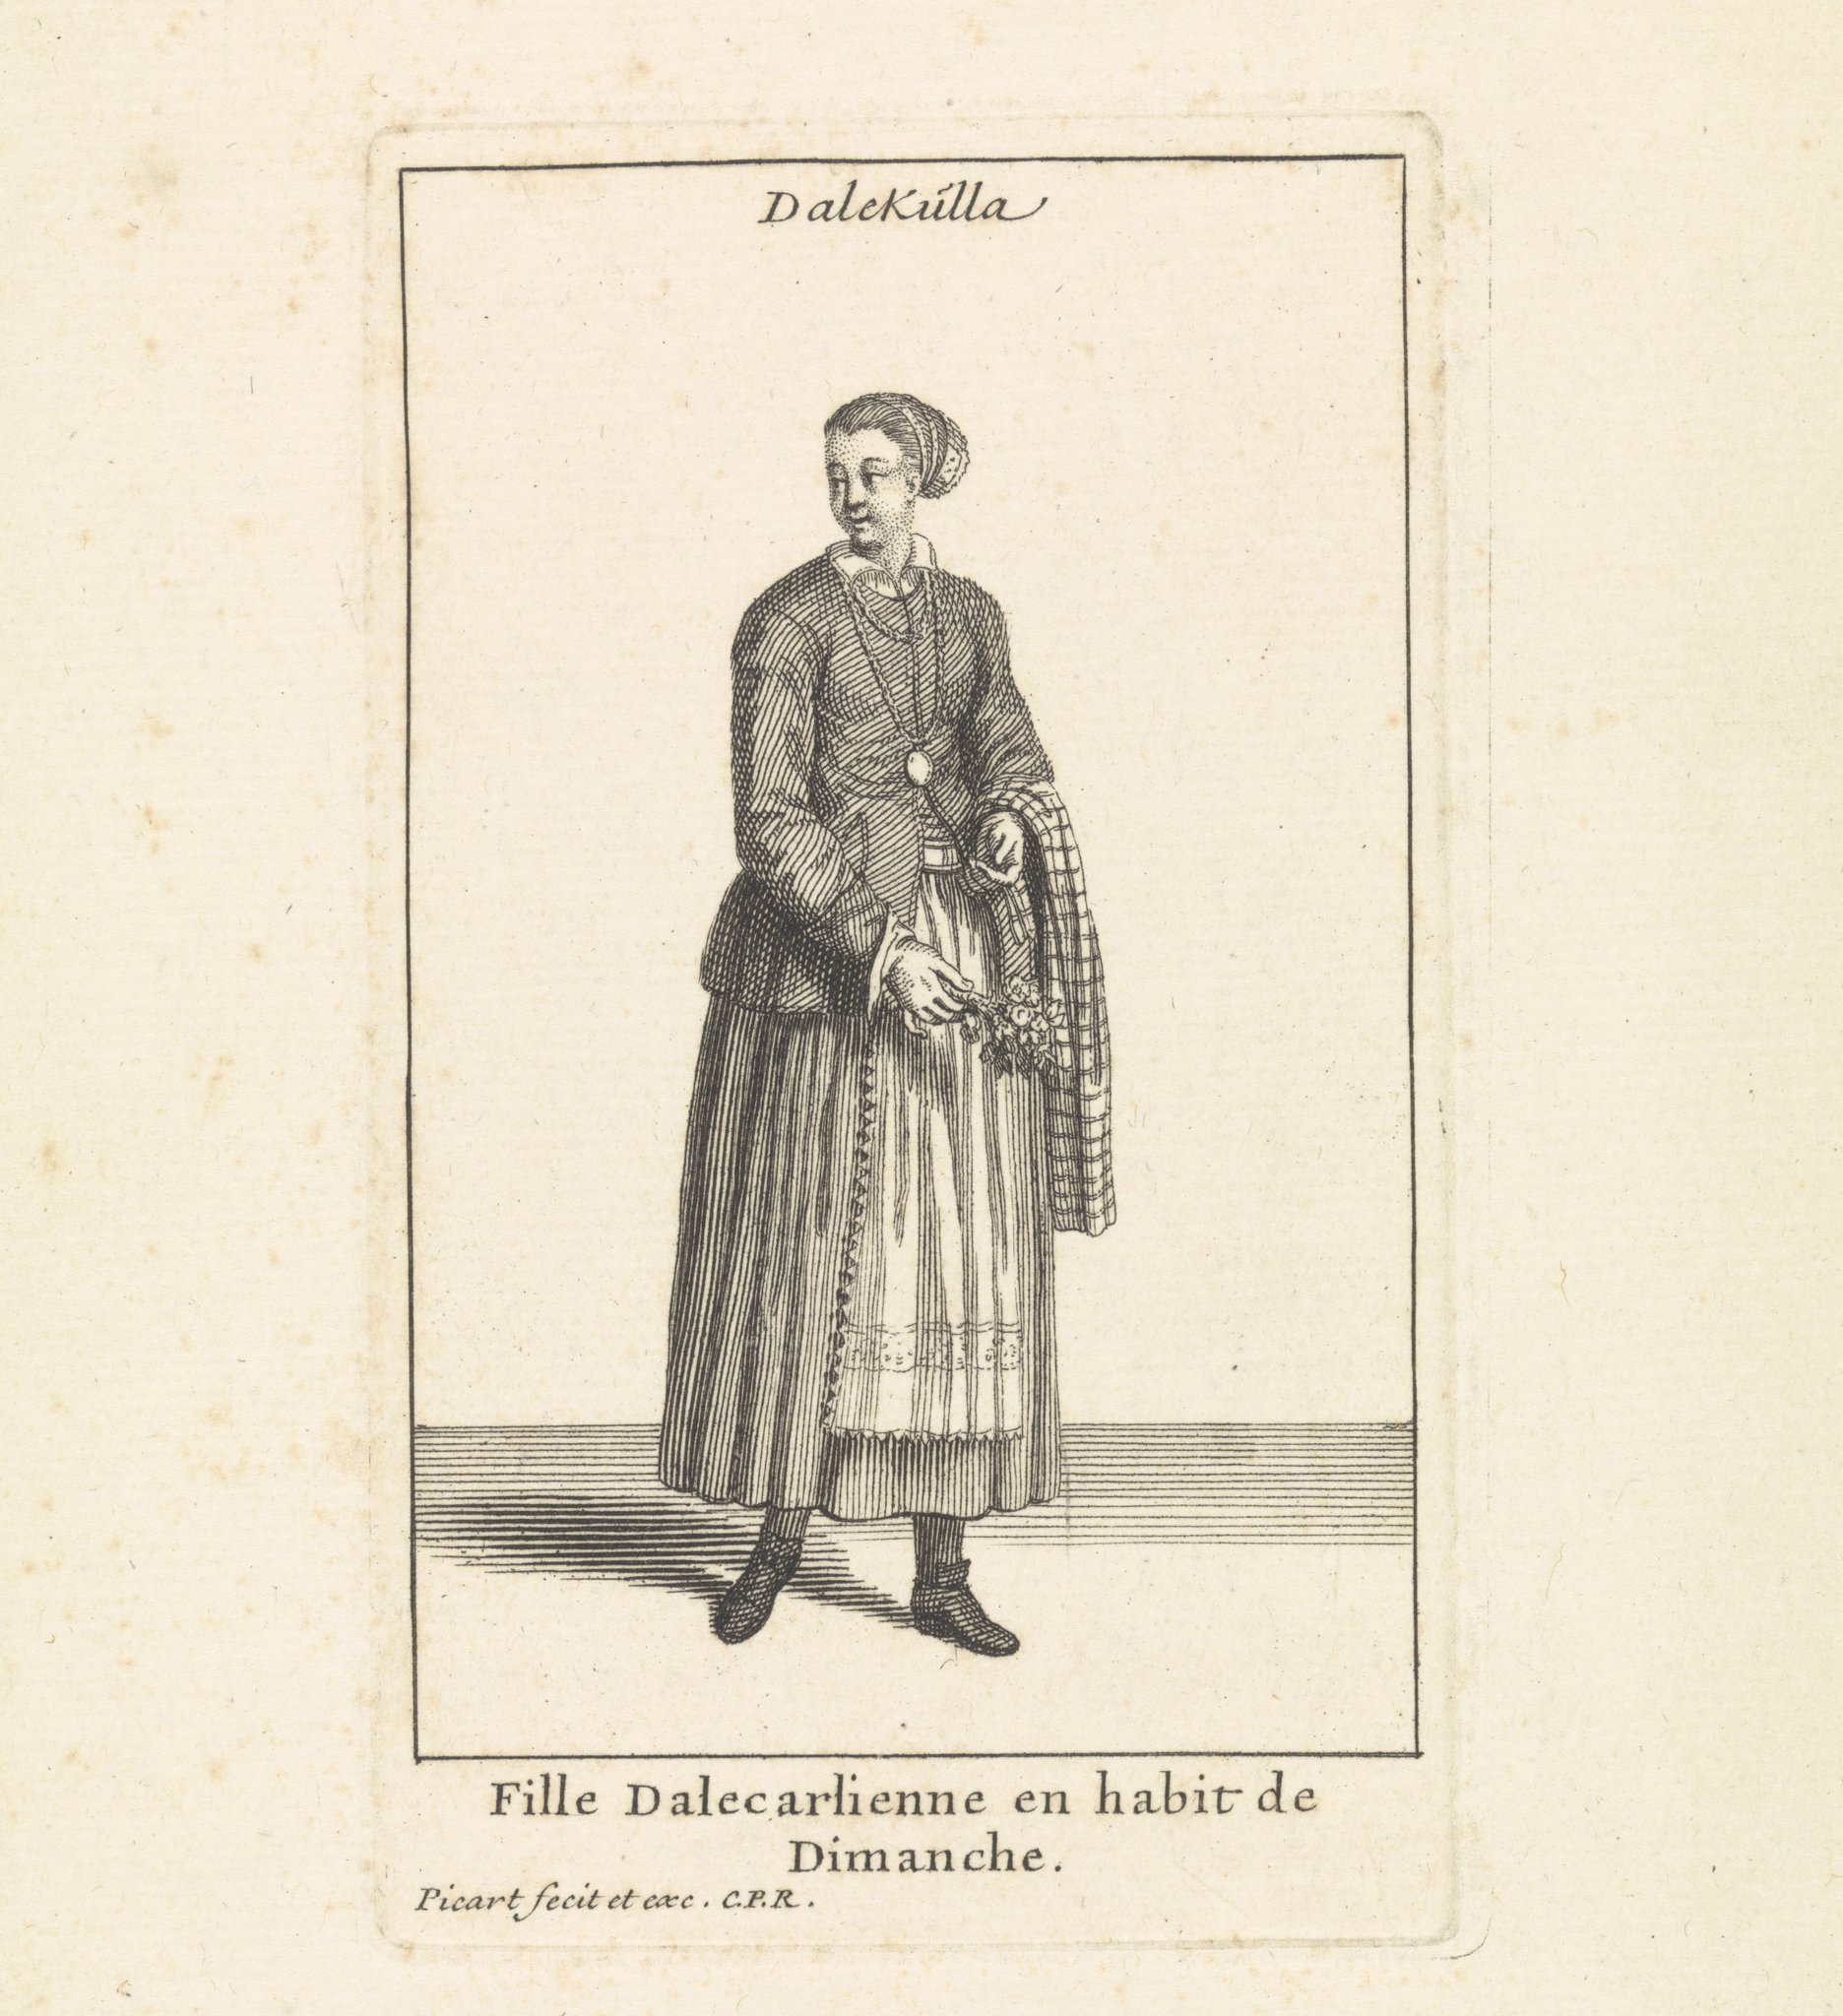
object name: print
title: Zweedse vrouw gekleed in zondagse kleding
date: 1704-1707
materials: paper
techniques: engraving, etching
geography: paris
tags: europeans (with name) (+ costume), clothes, costume (+ women's clothes)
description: Figuur in eigentijds kostuum. De prent heeft een titel in het Zweeds en een onderschrift in het Frans. Onder de voorstelling een achtregelig gedicht in het Frans en in het Zweeds.